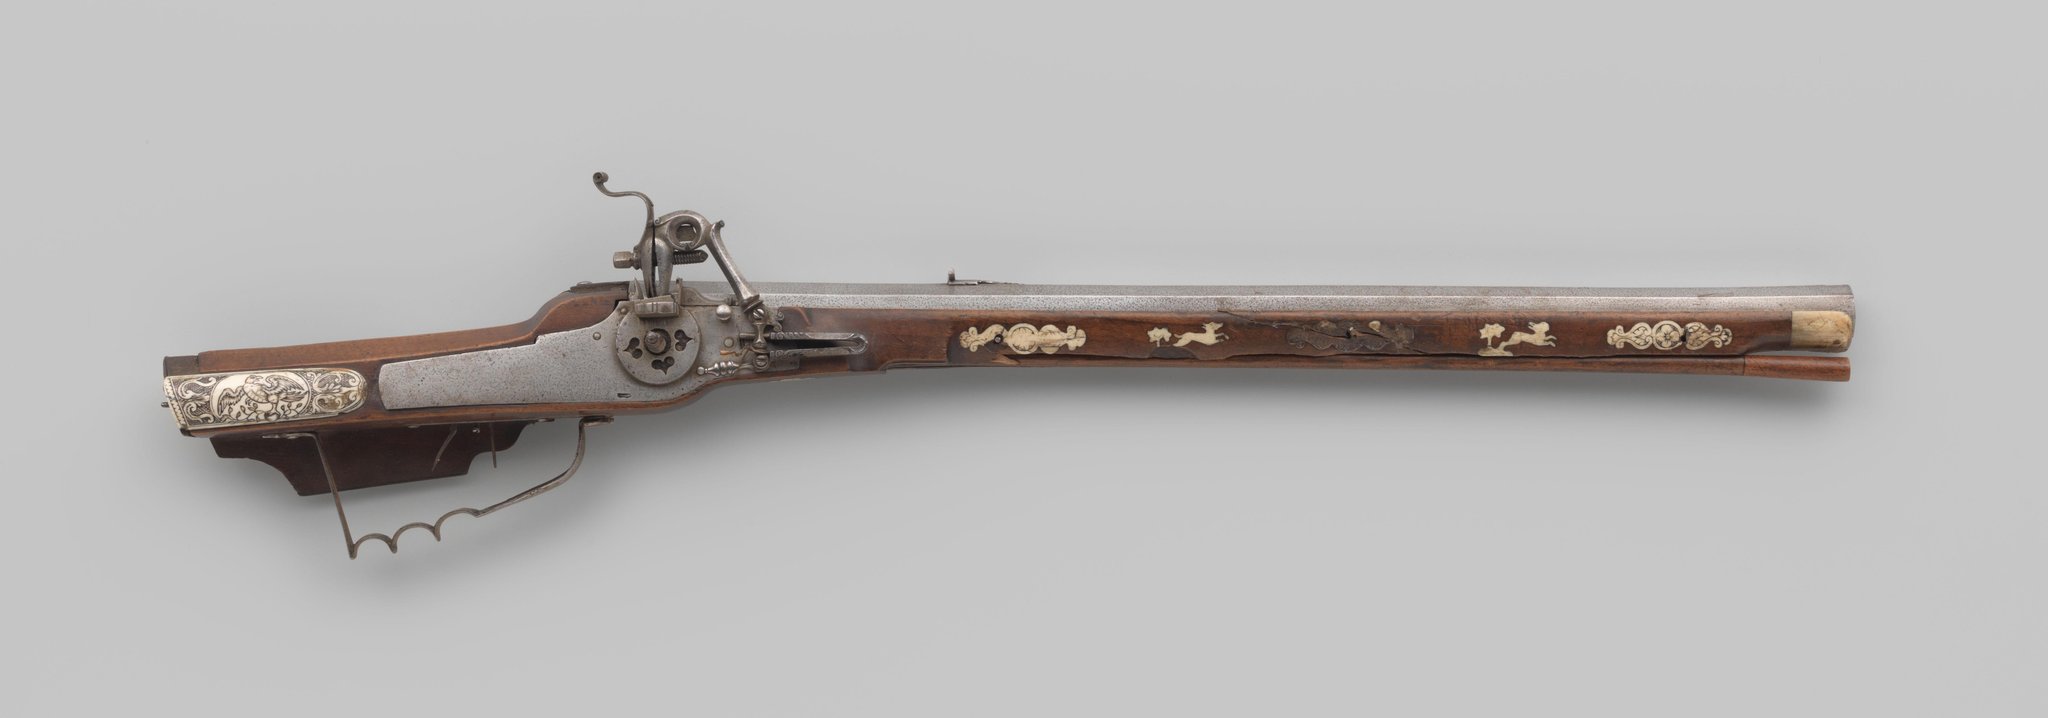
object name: radslotgeweer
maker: Anonymous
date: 1599-1699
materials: horn, iron, wood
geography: europe